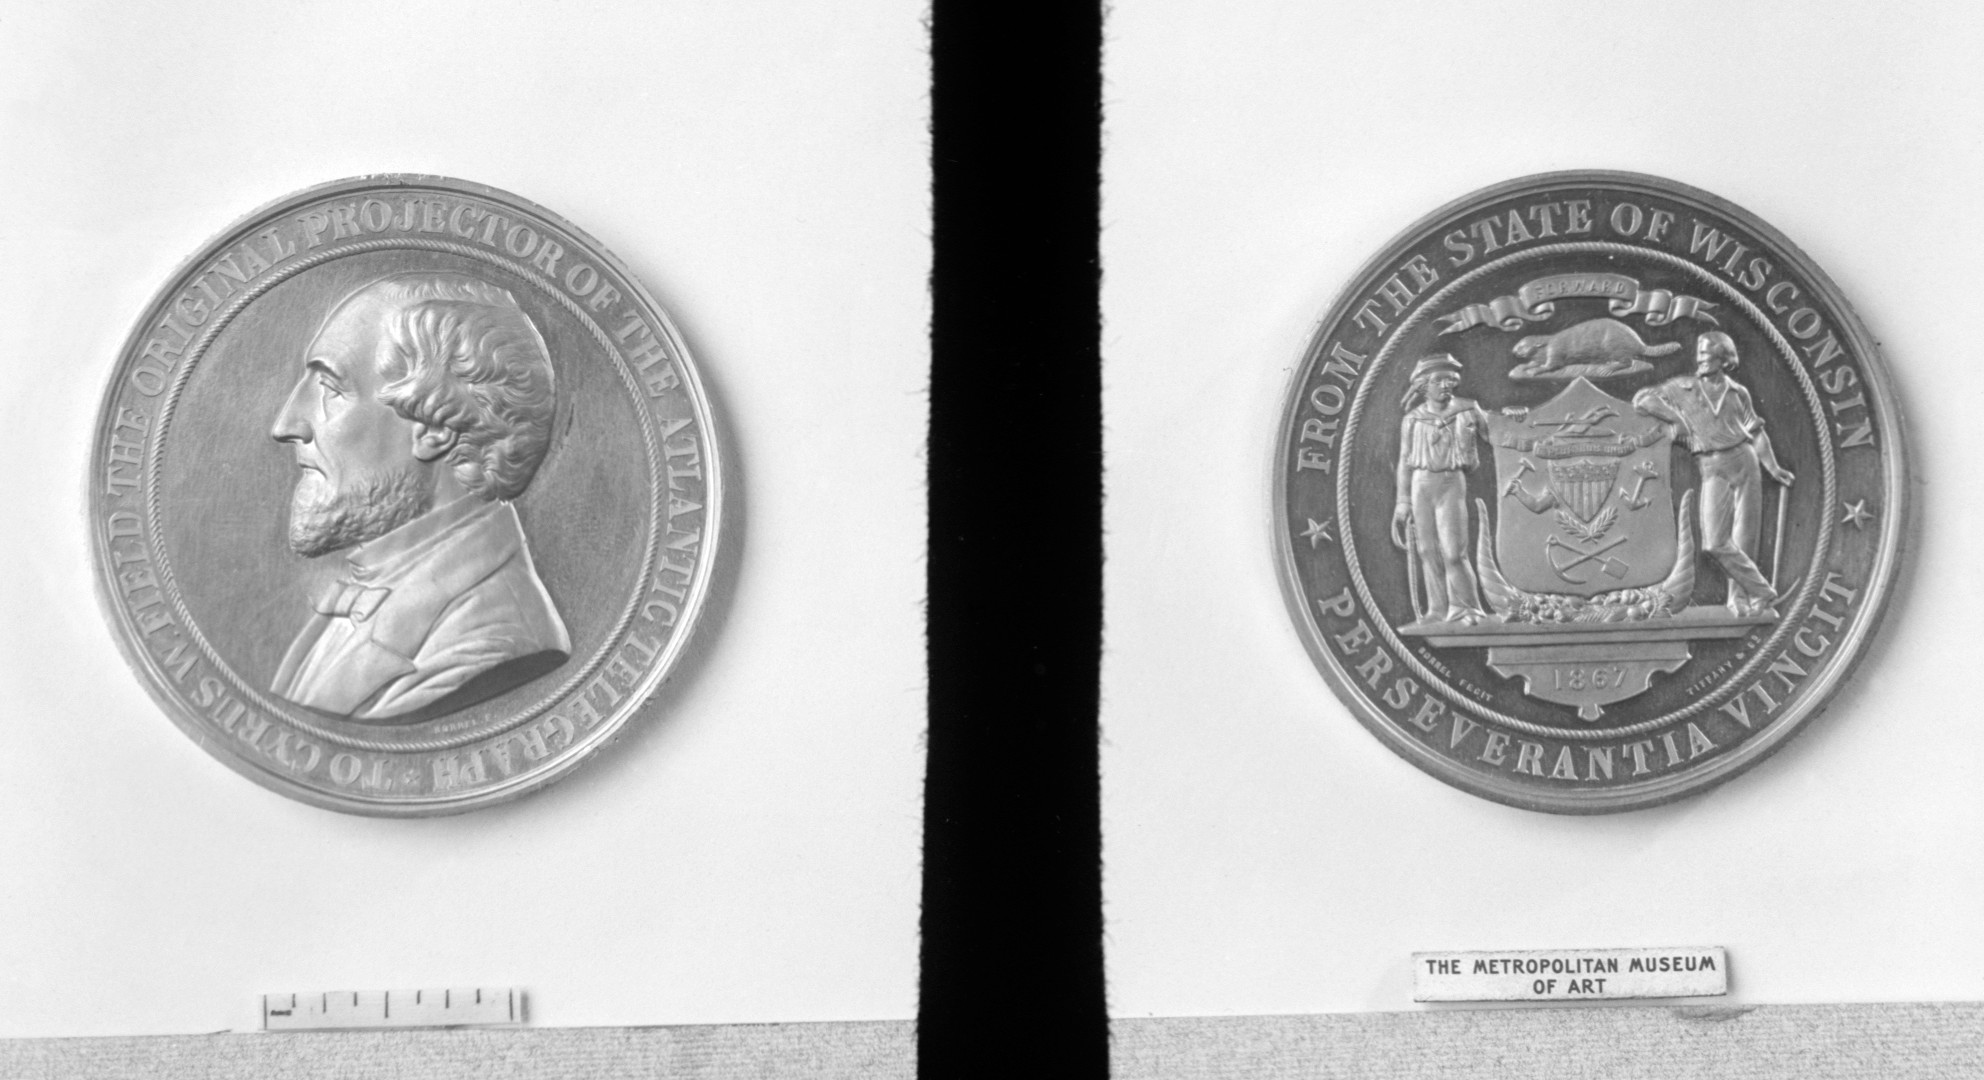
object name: medal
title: To C.W. Field, from the State of Wisconsin for laying the Atlantic Cable, 1867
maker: alfred borrel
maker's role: artist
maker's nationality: french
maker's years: 1836-1927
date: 1867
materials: gold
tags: men,profiles,coat of arms,transatlantic cable